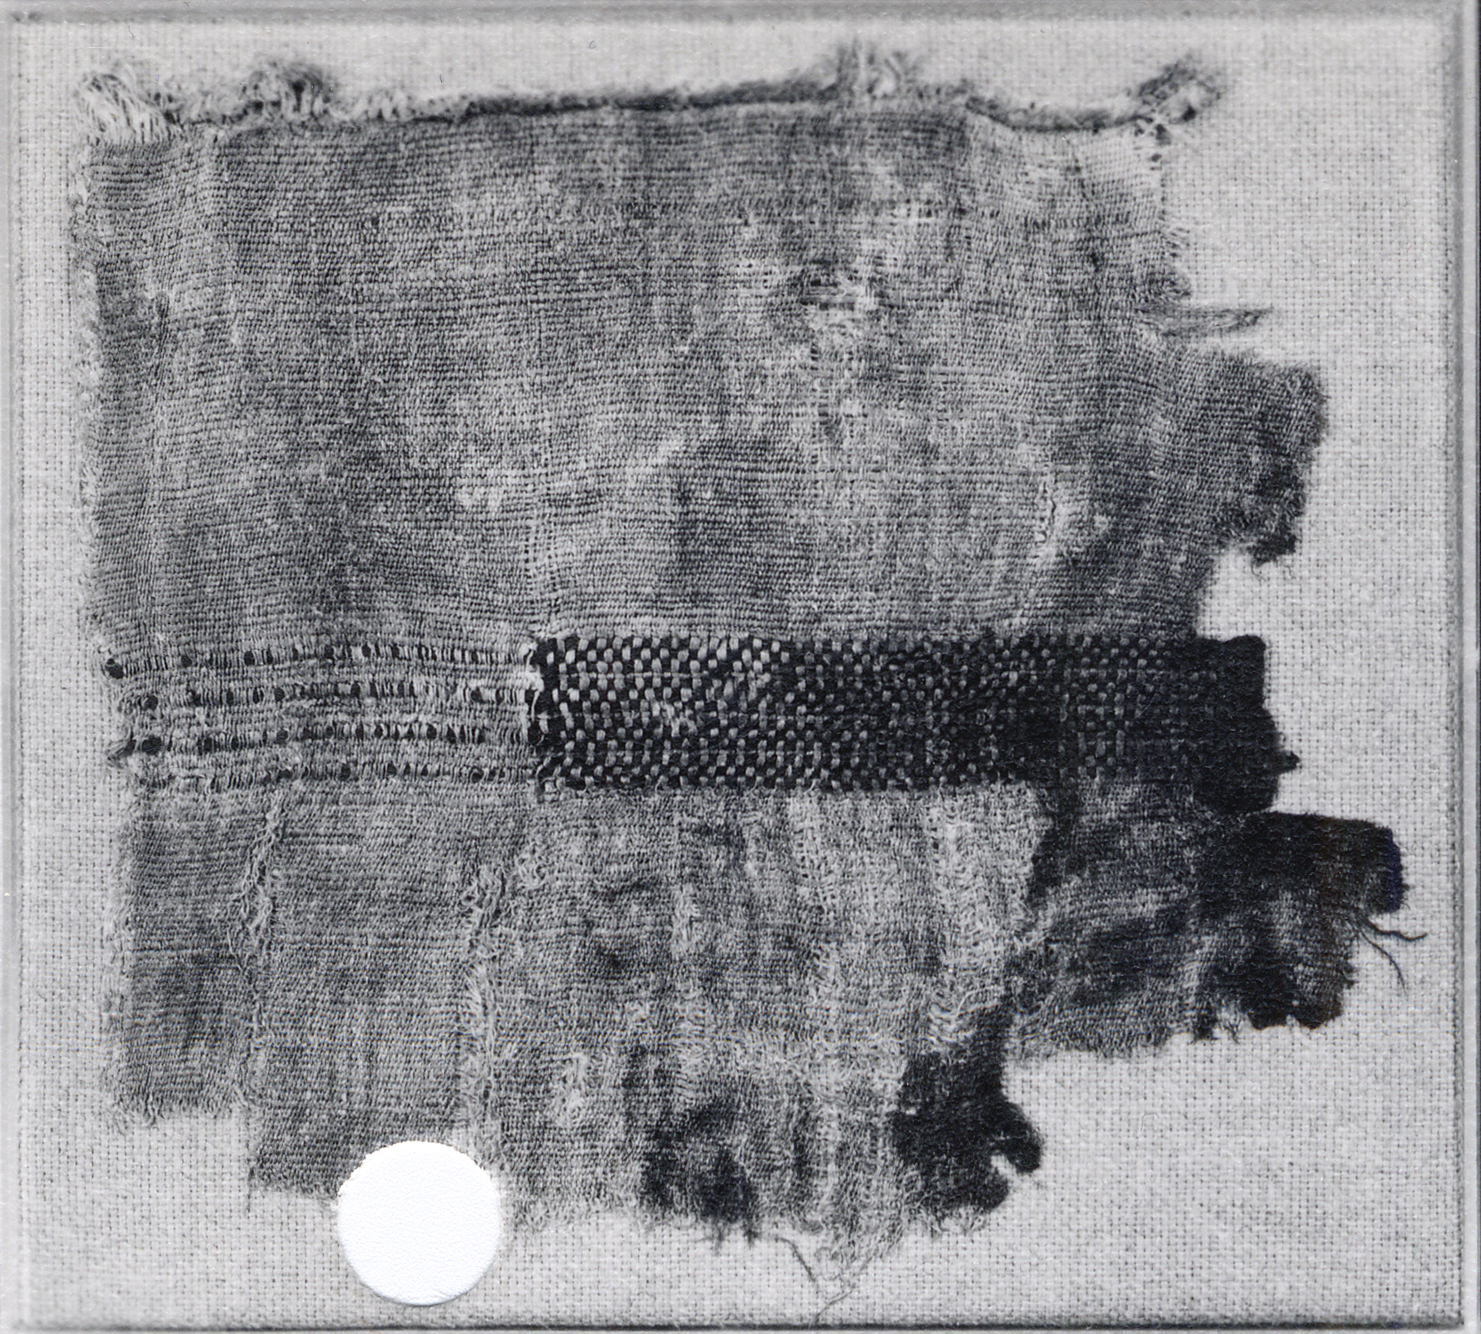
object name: dress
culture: coptic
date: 301-400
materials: linen, wool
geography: egypt